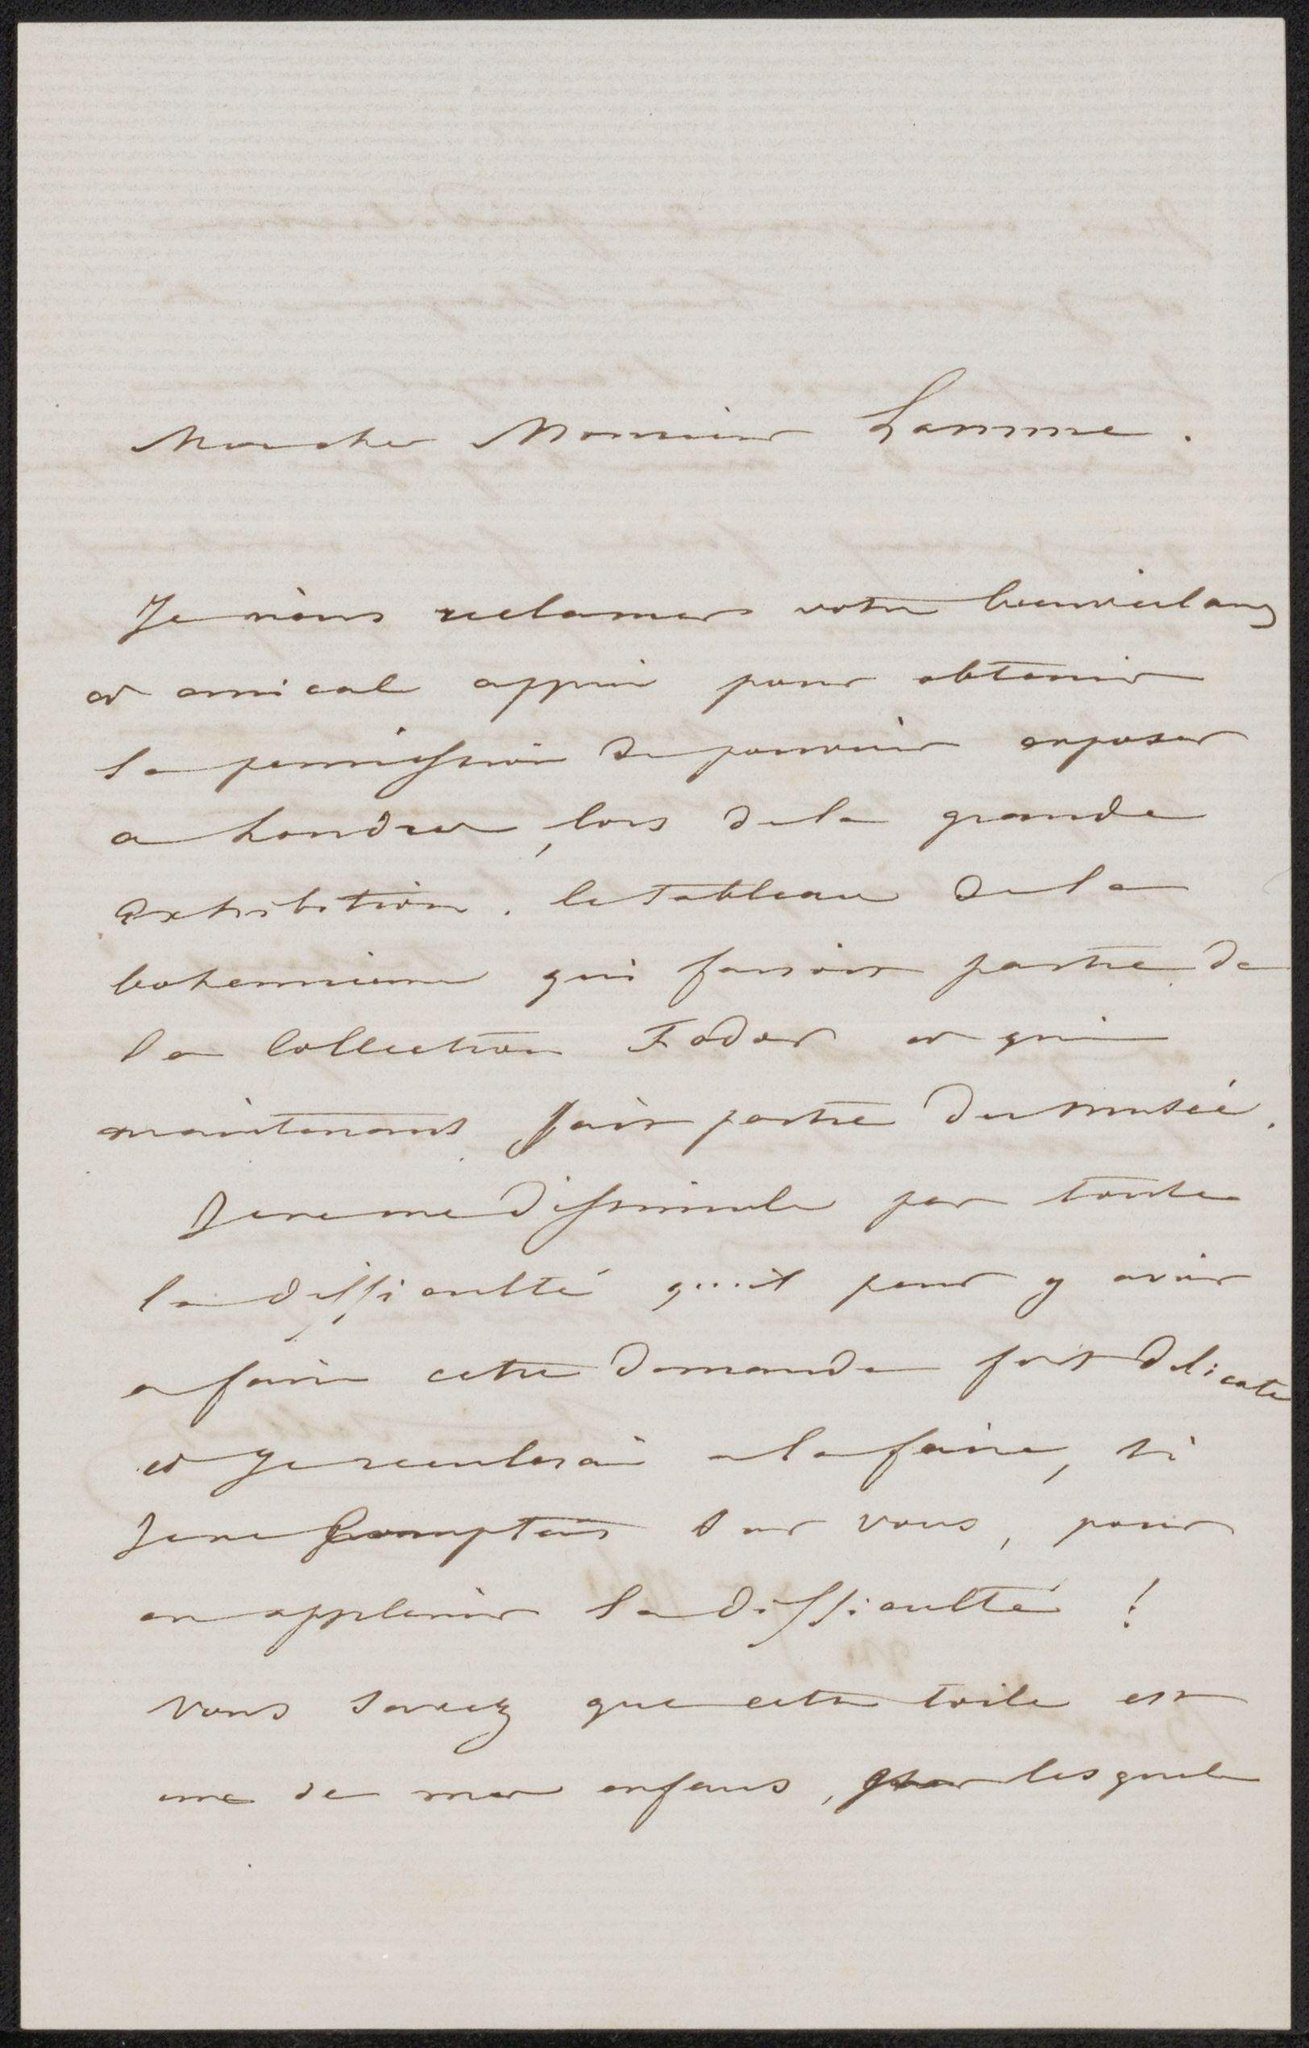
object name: letter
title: Brief aan Ary Johannes Lamme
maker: louis gallait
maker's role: draughtsman, painter, print maker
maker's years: 1810-1887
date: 1861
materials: ink, paper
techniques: pen, writing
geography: brussels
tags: dordrecht, ary johannes lamme, amsterdam, carl joseph fodor, painting (including book-illumination, miniature-painting), exhibition ~ art, art collecting, london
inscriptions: collector's mark: Lugt 2228